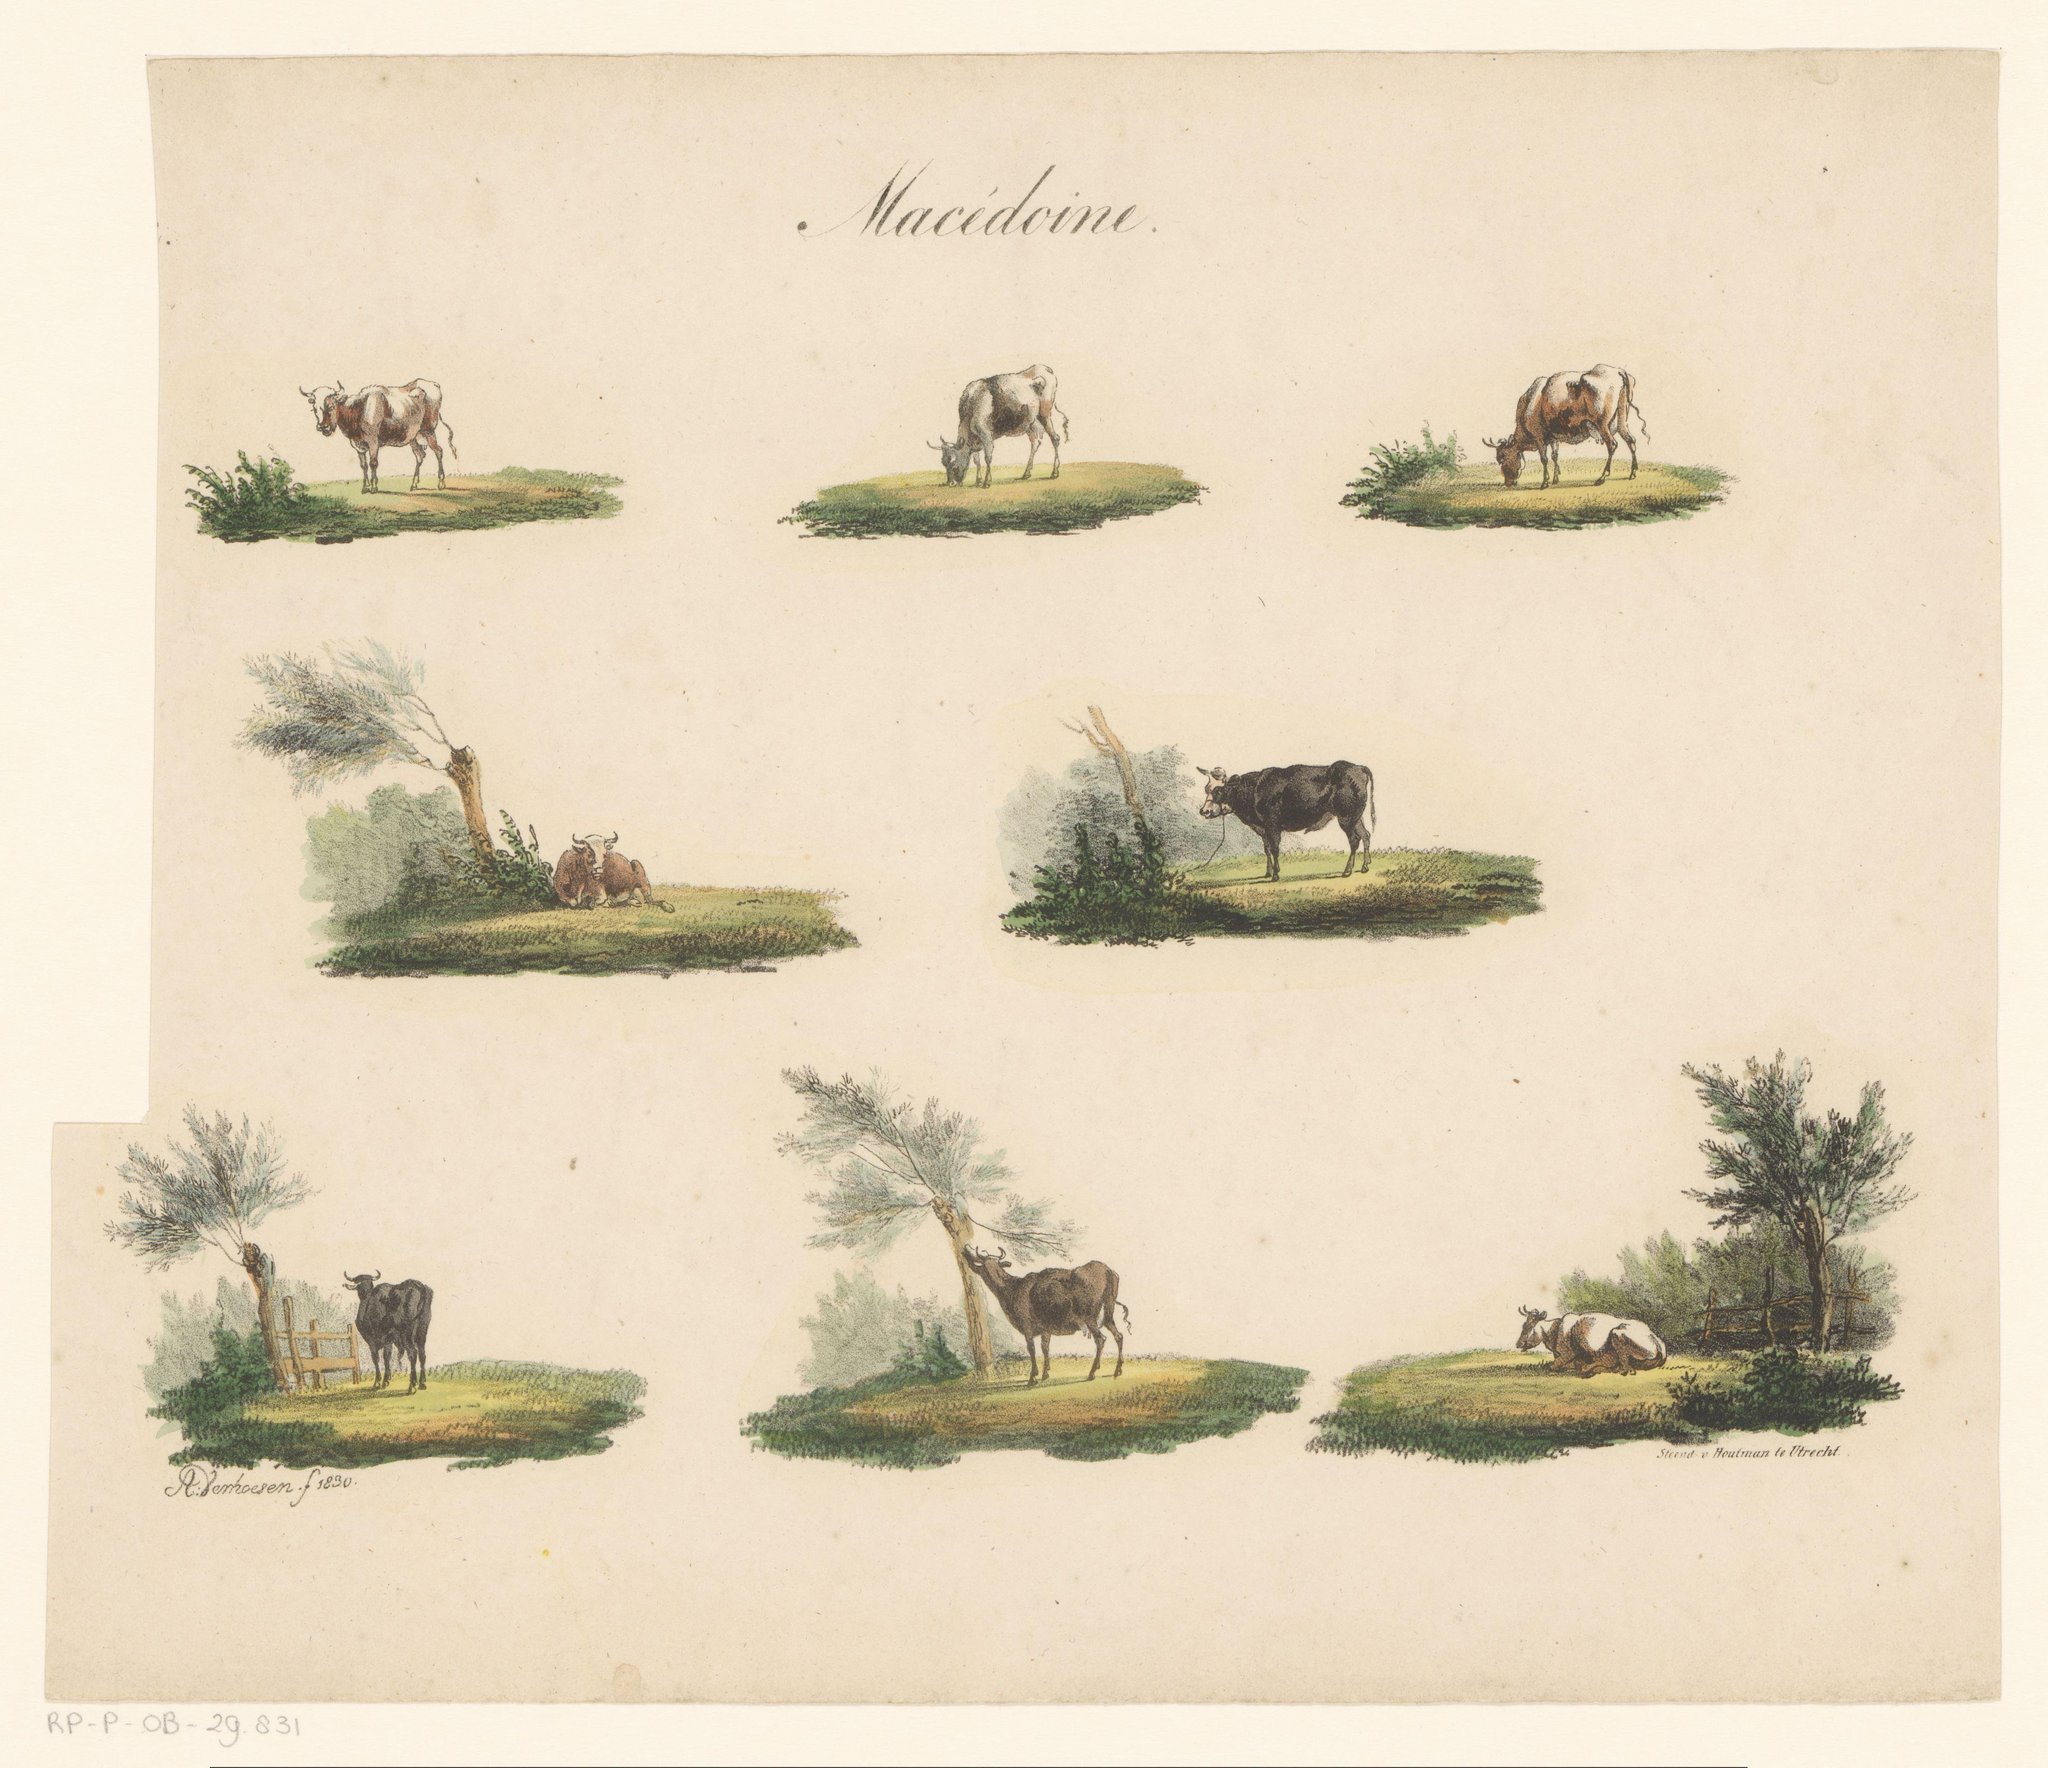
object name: print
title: Macédoine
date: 1830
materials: paper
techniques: hand coloring, lithograph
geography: utrecht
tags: cow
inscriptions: collector's mark: Lugt 2228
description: Negen afbeeldingen van koeien in een landschap.